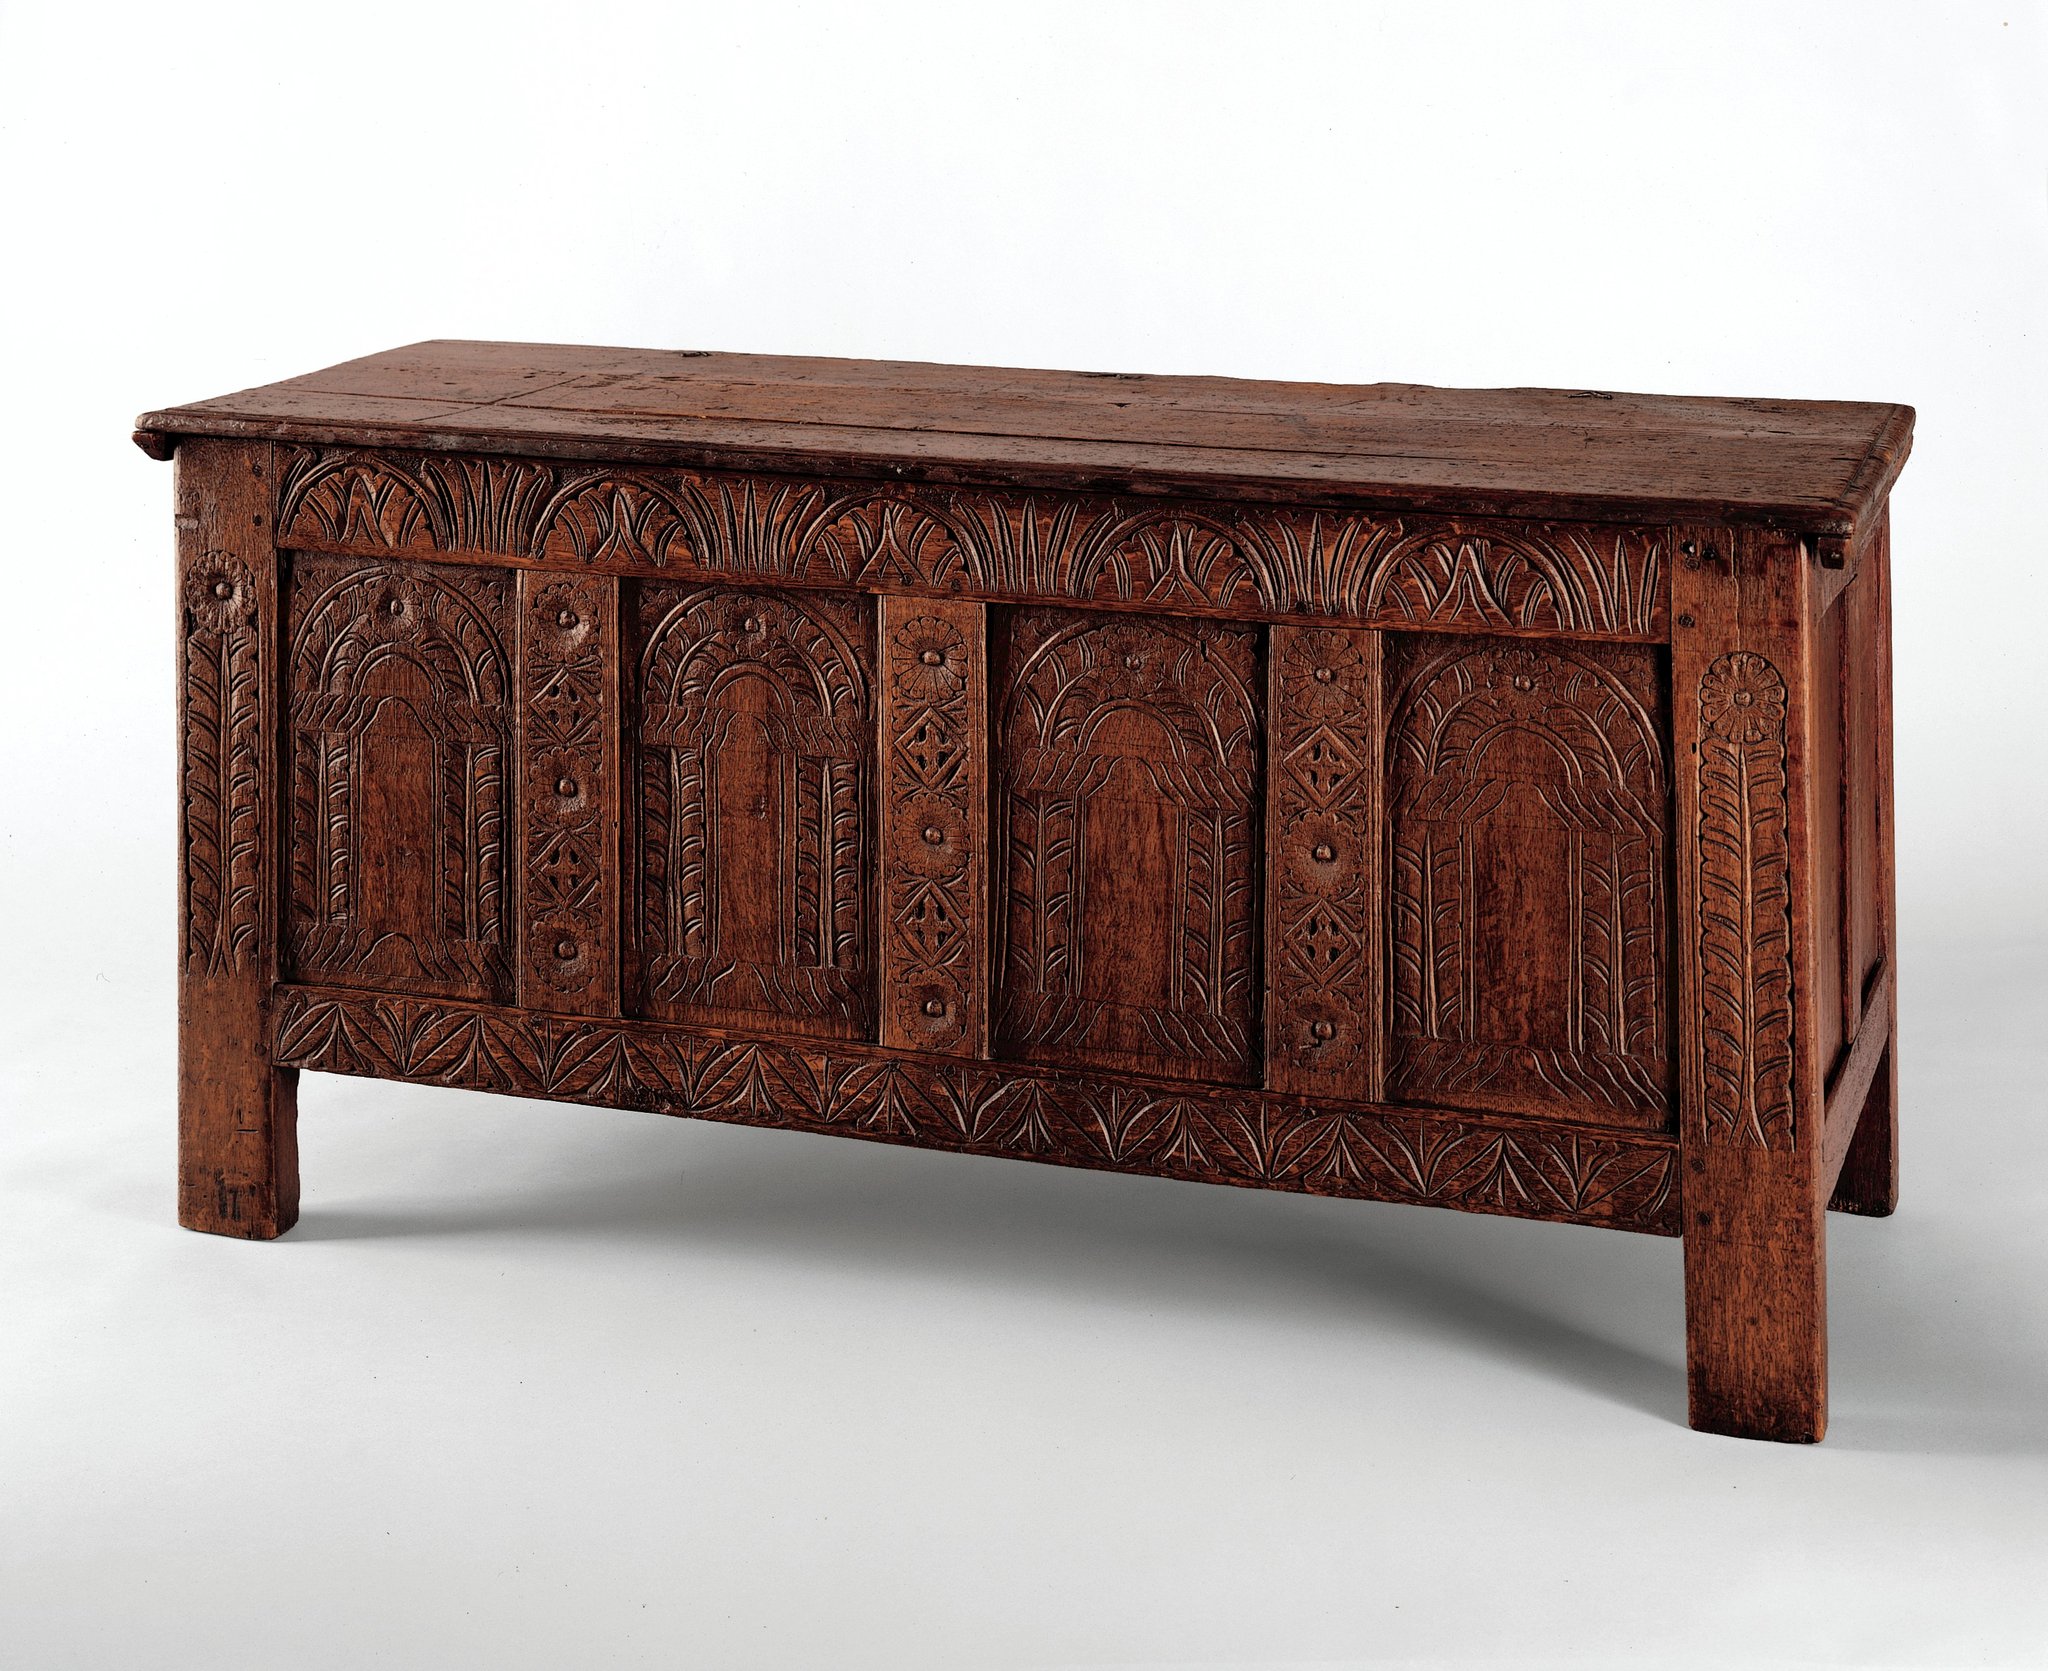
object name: chest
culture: american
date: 1650-1680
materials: wood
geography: united states